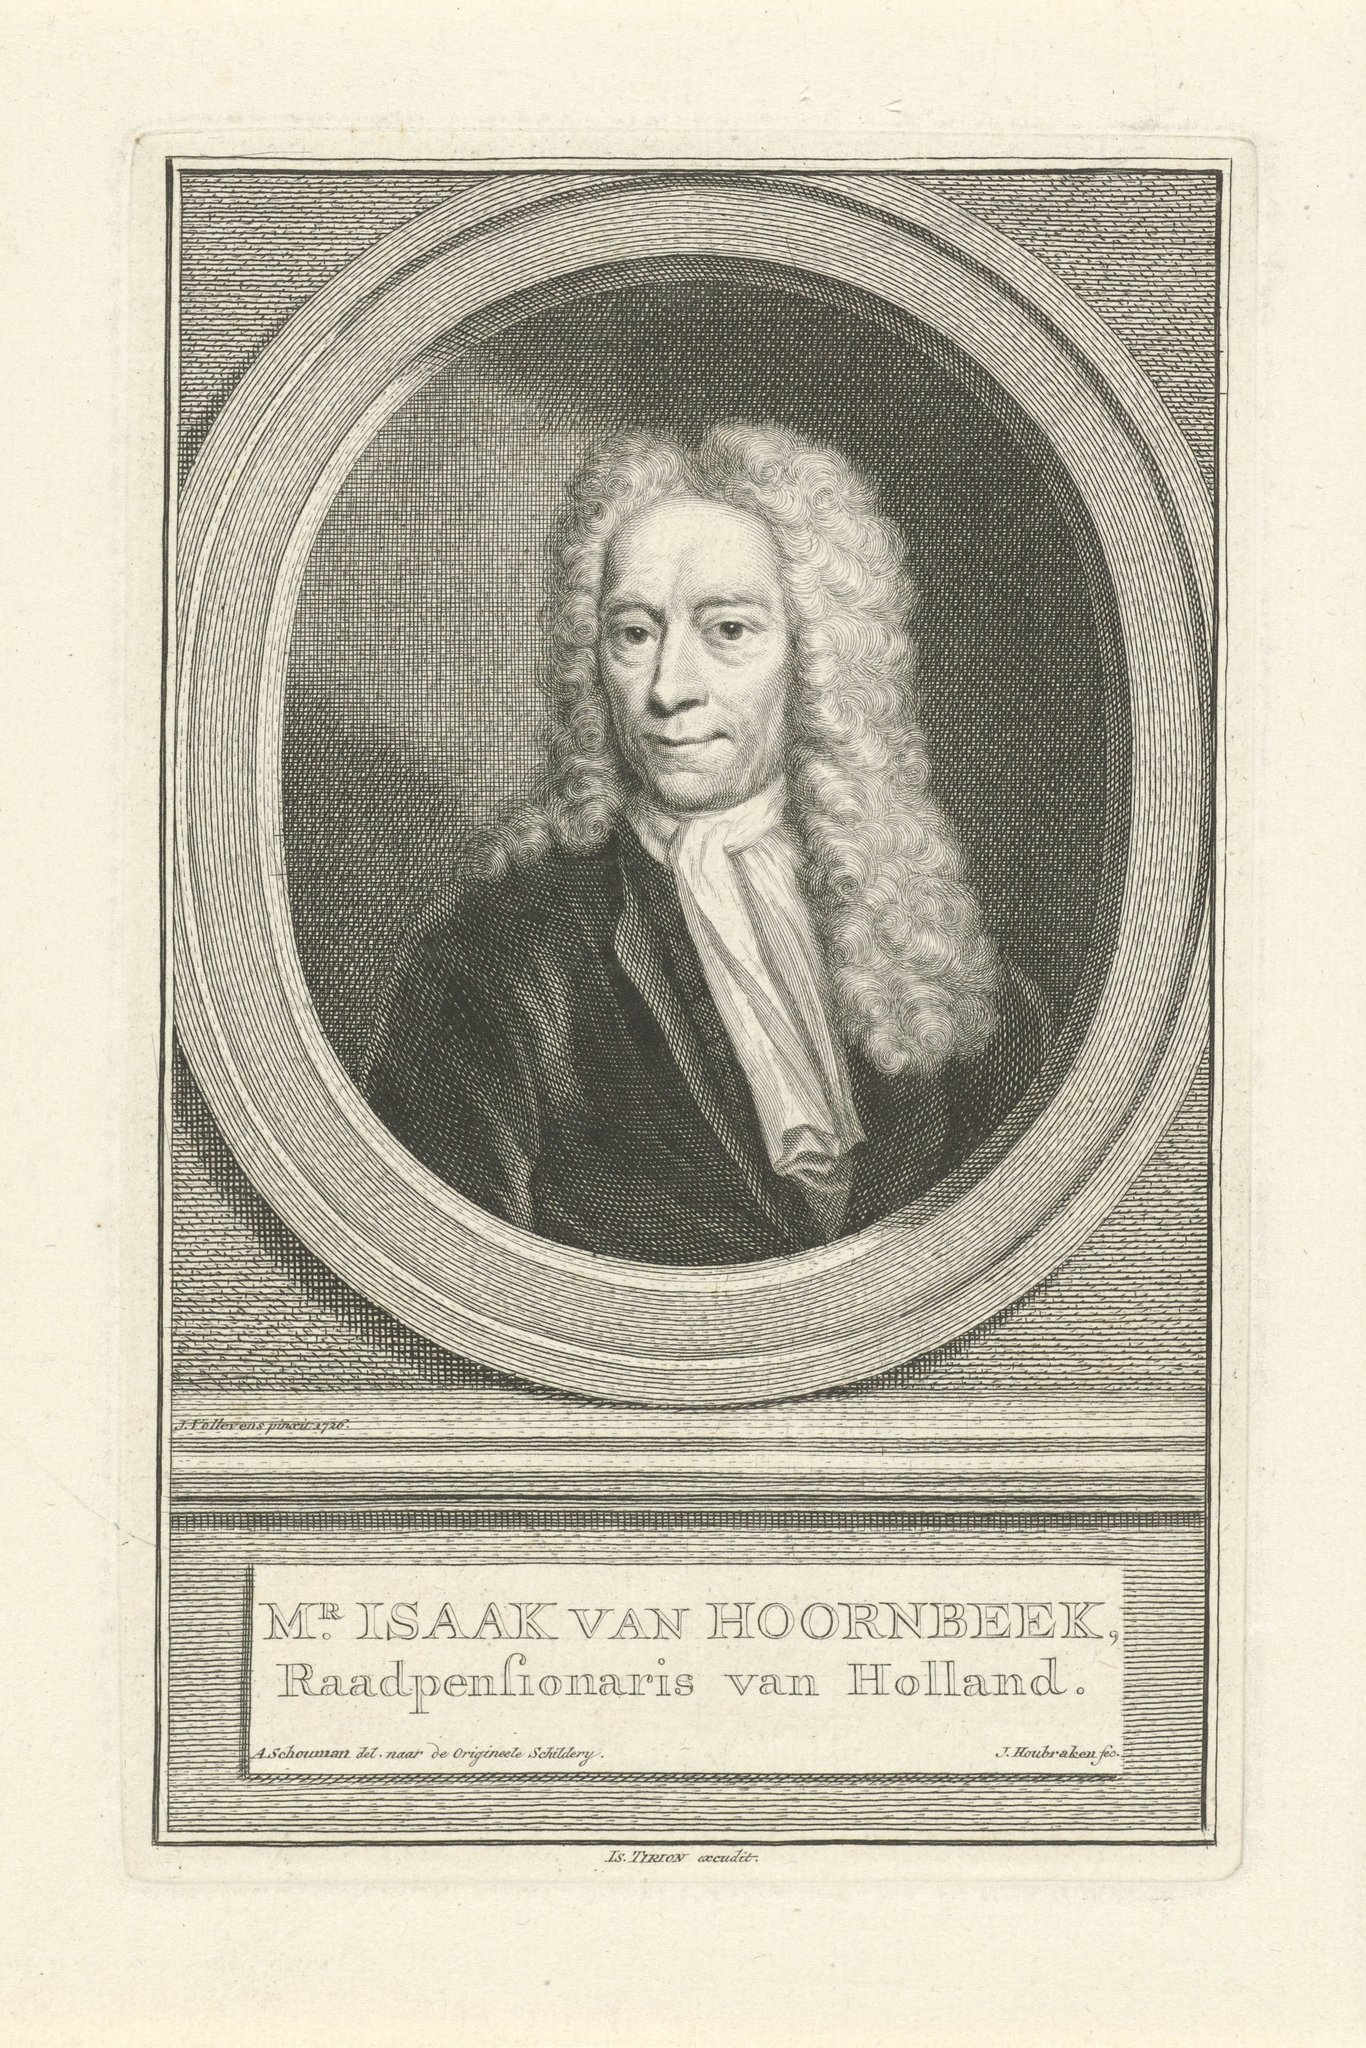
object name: print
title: Portret van Isaac van Hoornbeek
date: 1749-1759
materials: paper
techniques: engraving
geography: amsterdam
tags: leiden, the hague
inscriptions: collector's mark: Lugt 2228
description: Prent ook gebruikt in: Jan Wagenaar, Vaderlandsche historie, vervattende de geschiedenissen der nu Vereenigde Nederlanden, inzonderheid die van Holland (...), 21 delen. Amsterdam, Isaak Tirion, 1749-59.